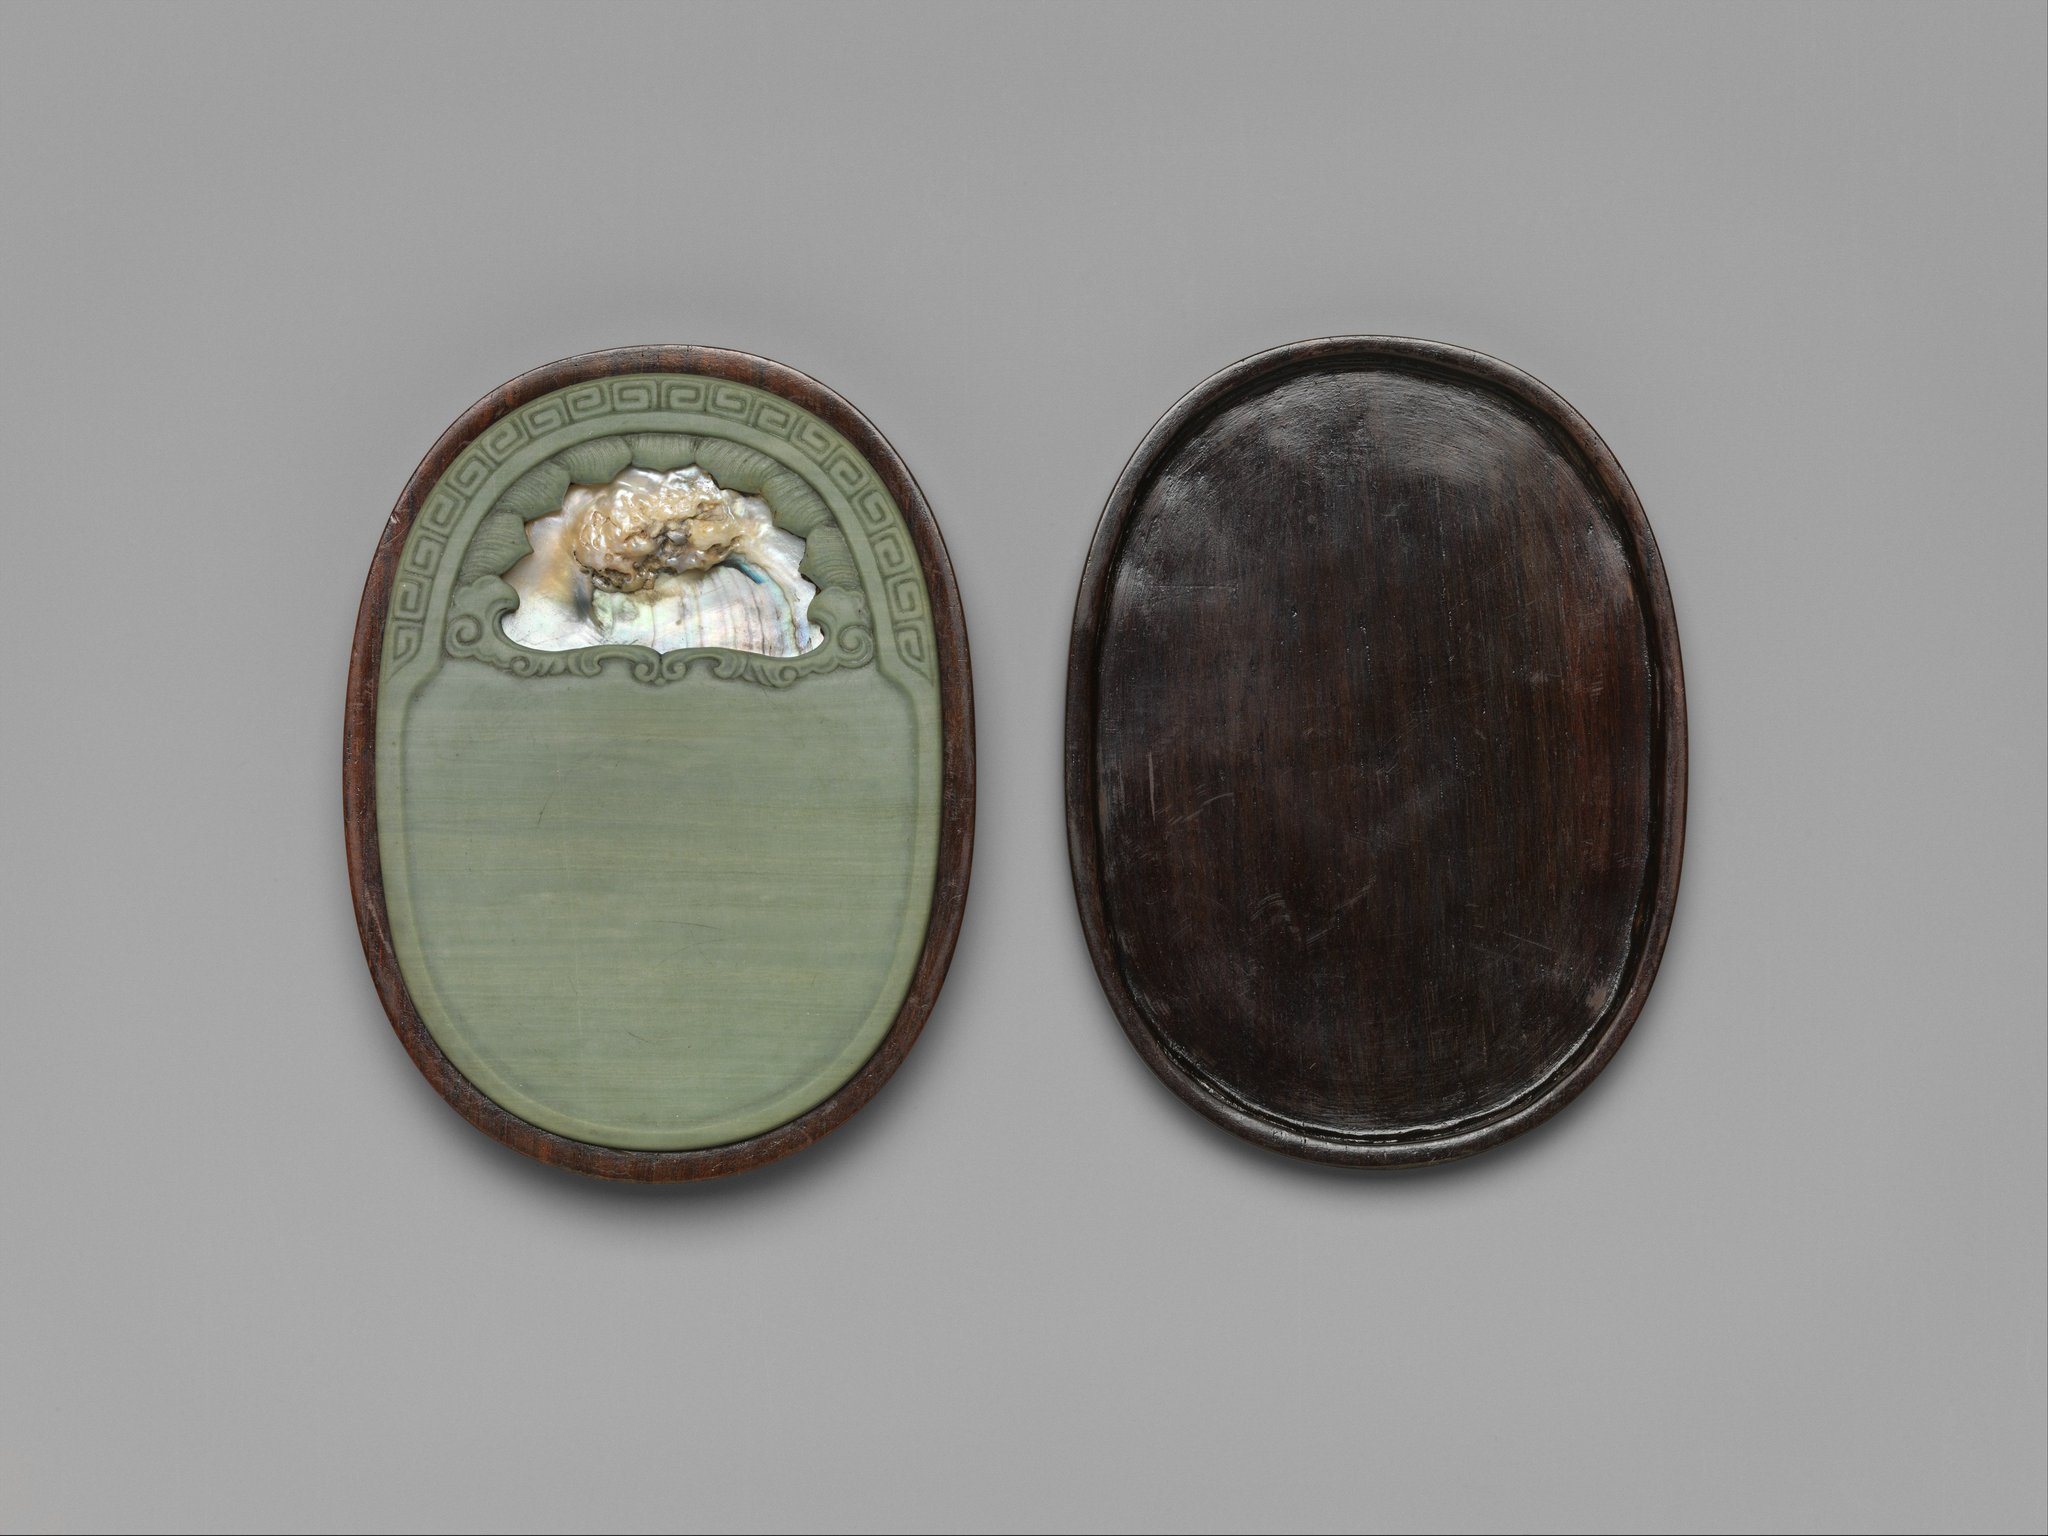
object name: ink pallet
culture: chinese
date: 1662-1722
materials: mother of pearl